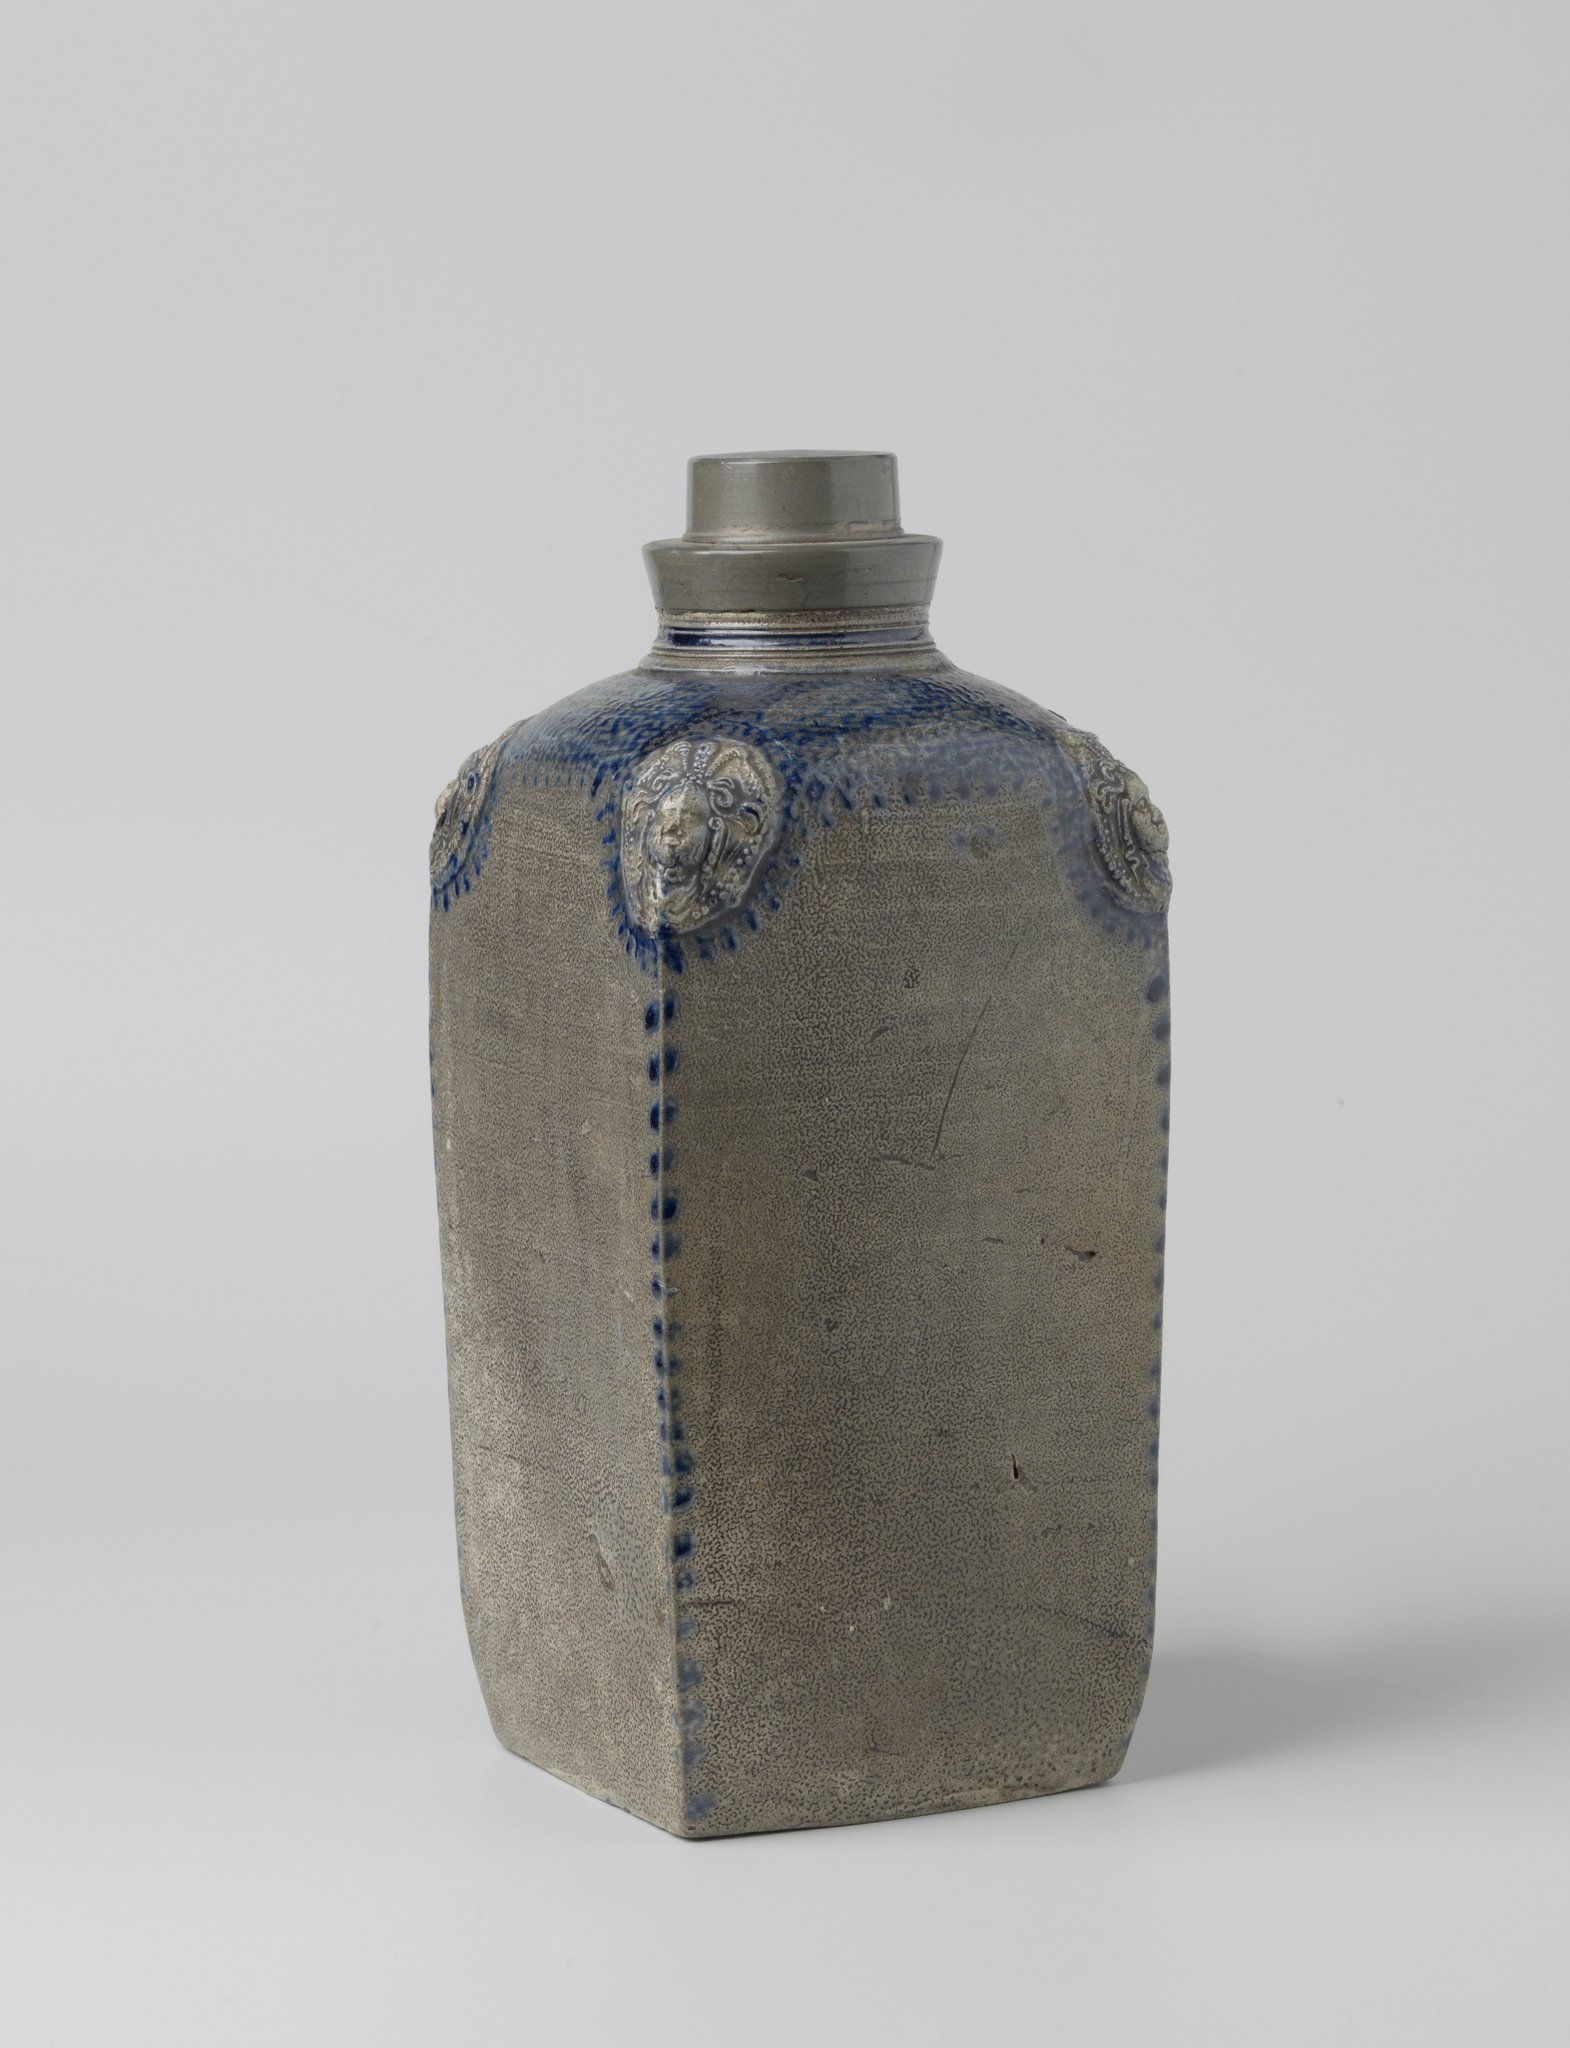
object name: jug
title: Square bottle with lion heads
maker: Anonymous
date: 1640-1700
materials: cobalt, glaze, stoneware, tin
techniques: firing, forming, relief, turning, vitrification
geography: westerwald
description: Vierkante fles van steengoed met een ronde schouder en korte, smalle nek. Enkele profielen op de nek. Gedeeltelijk bedekt met kobaltblauw. Op elke hoek van de schouder een gedrukte en opgelegde reliëfdecoratie van een leeuwenkop; de schouder en hoeken met blauwe stippen. Aan de nek bevestigd een tinnen montuur met schroefdop. Westerwald.